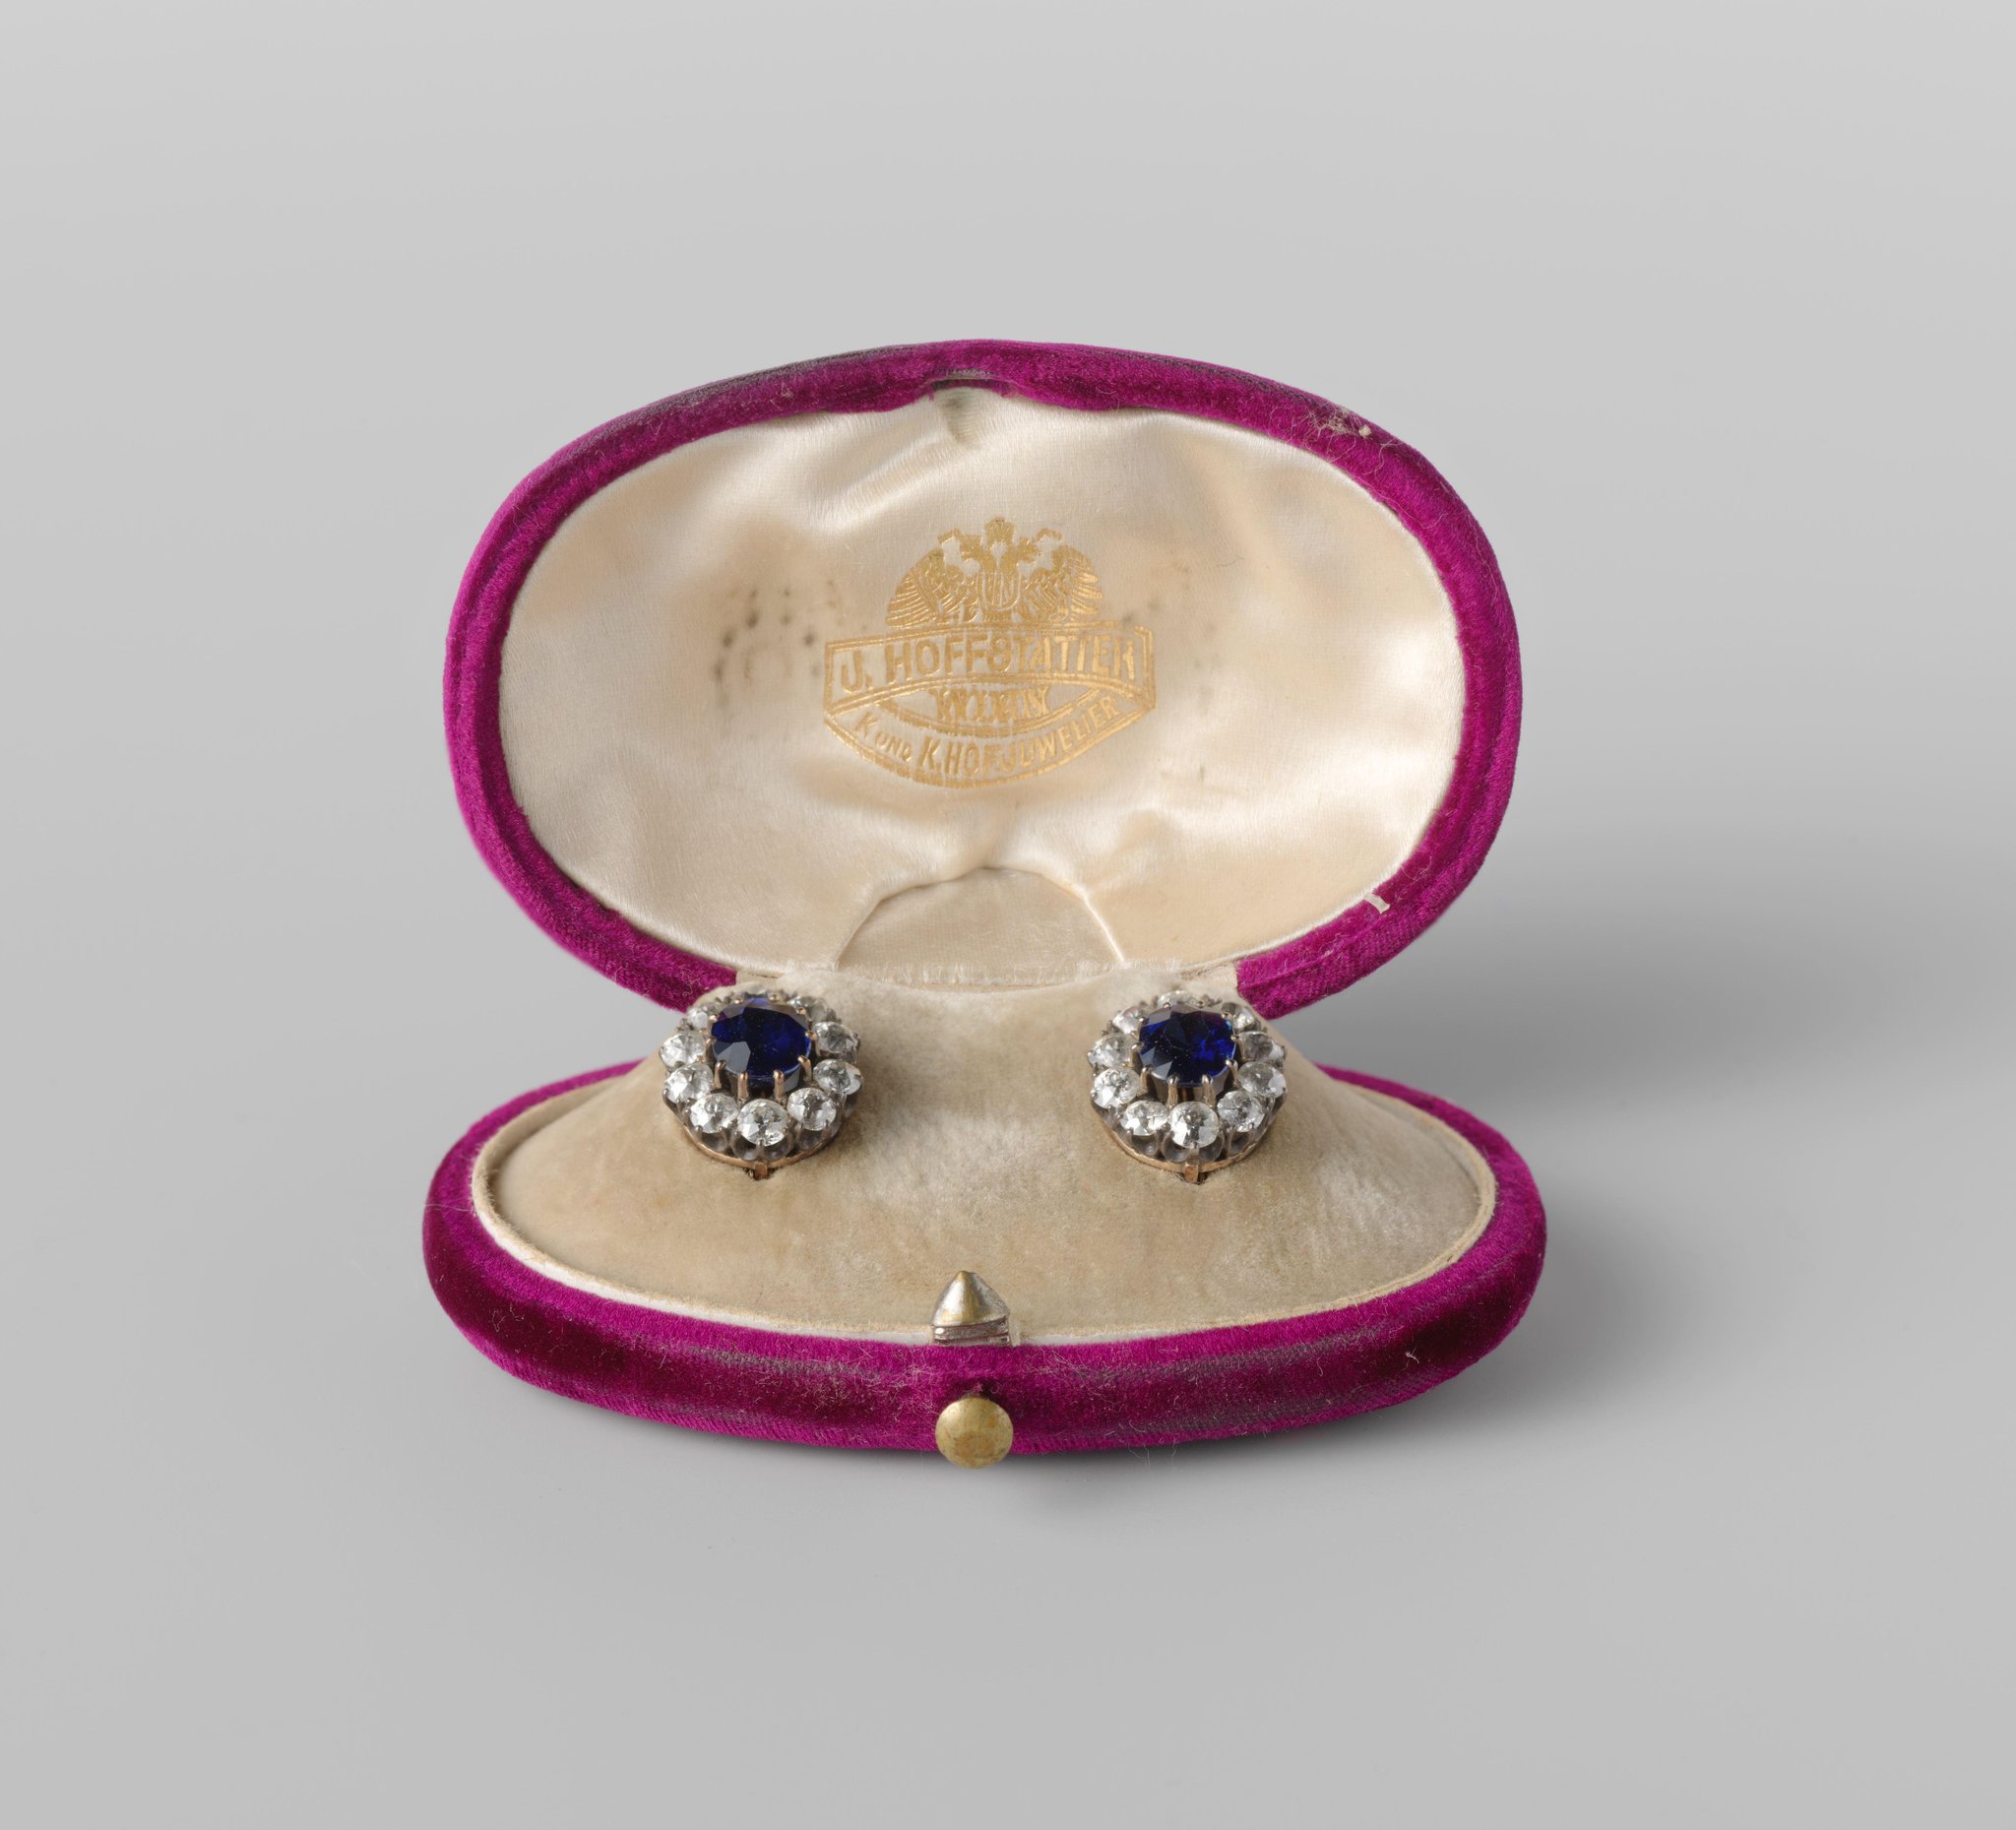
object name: earring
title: Paar oorbellen in juwelendoos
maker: Anonymous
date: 1800-1900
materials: gold, gemstone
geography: vienna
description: Een paar oorbellen met in het midden een blauwe saffier, omgeven door 10 briljanten.